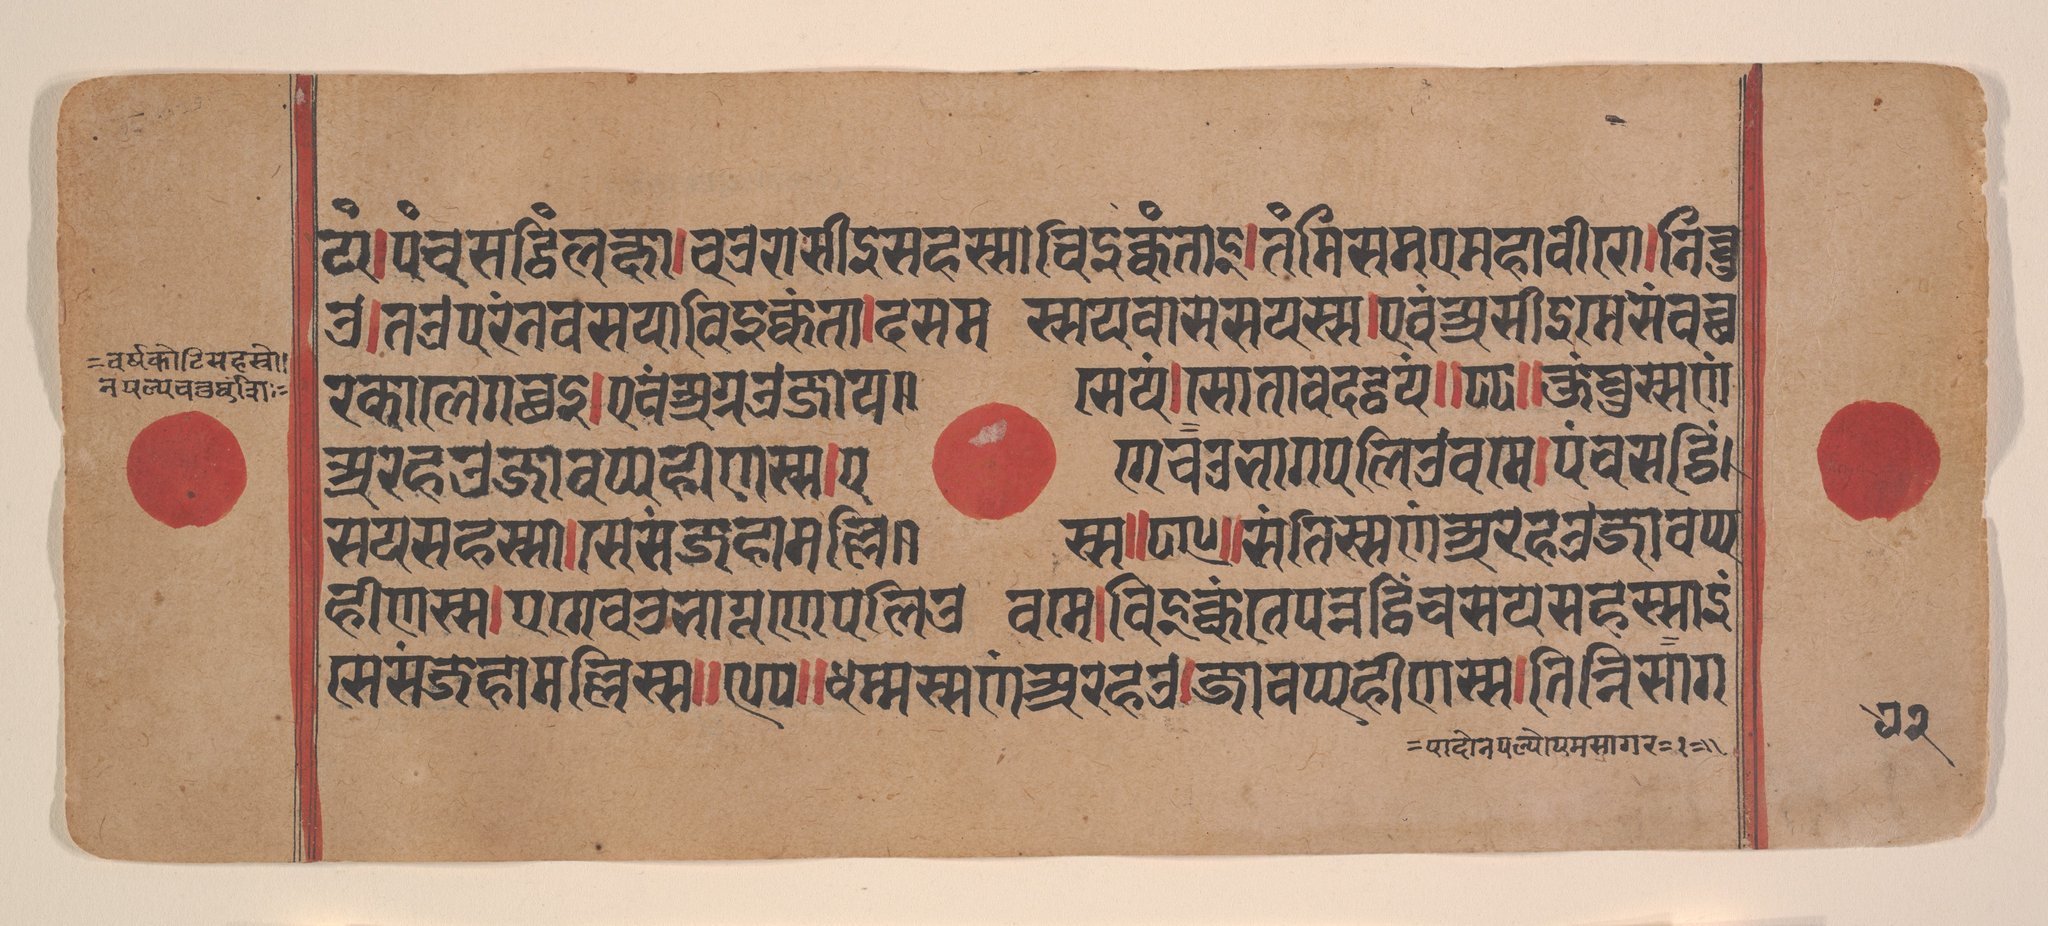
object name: folio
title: Page from a Dispersed Kalpa Sutra (Jain Book of Rituals)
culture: indian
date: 1401-1500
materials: gold, ink, paper, watercolor